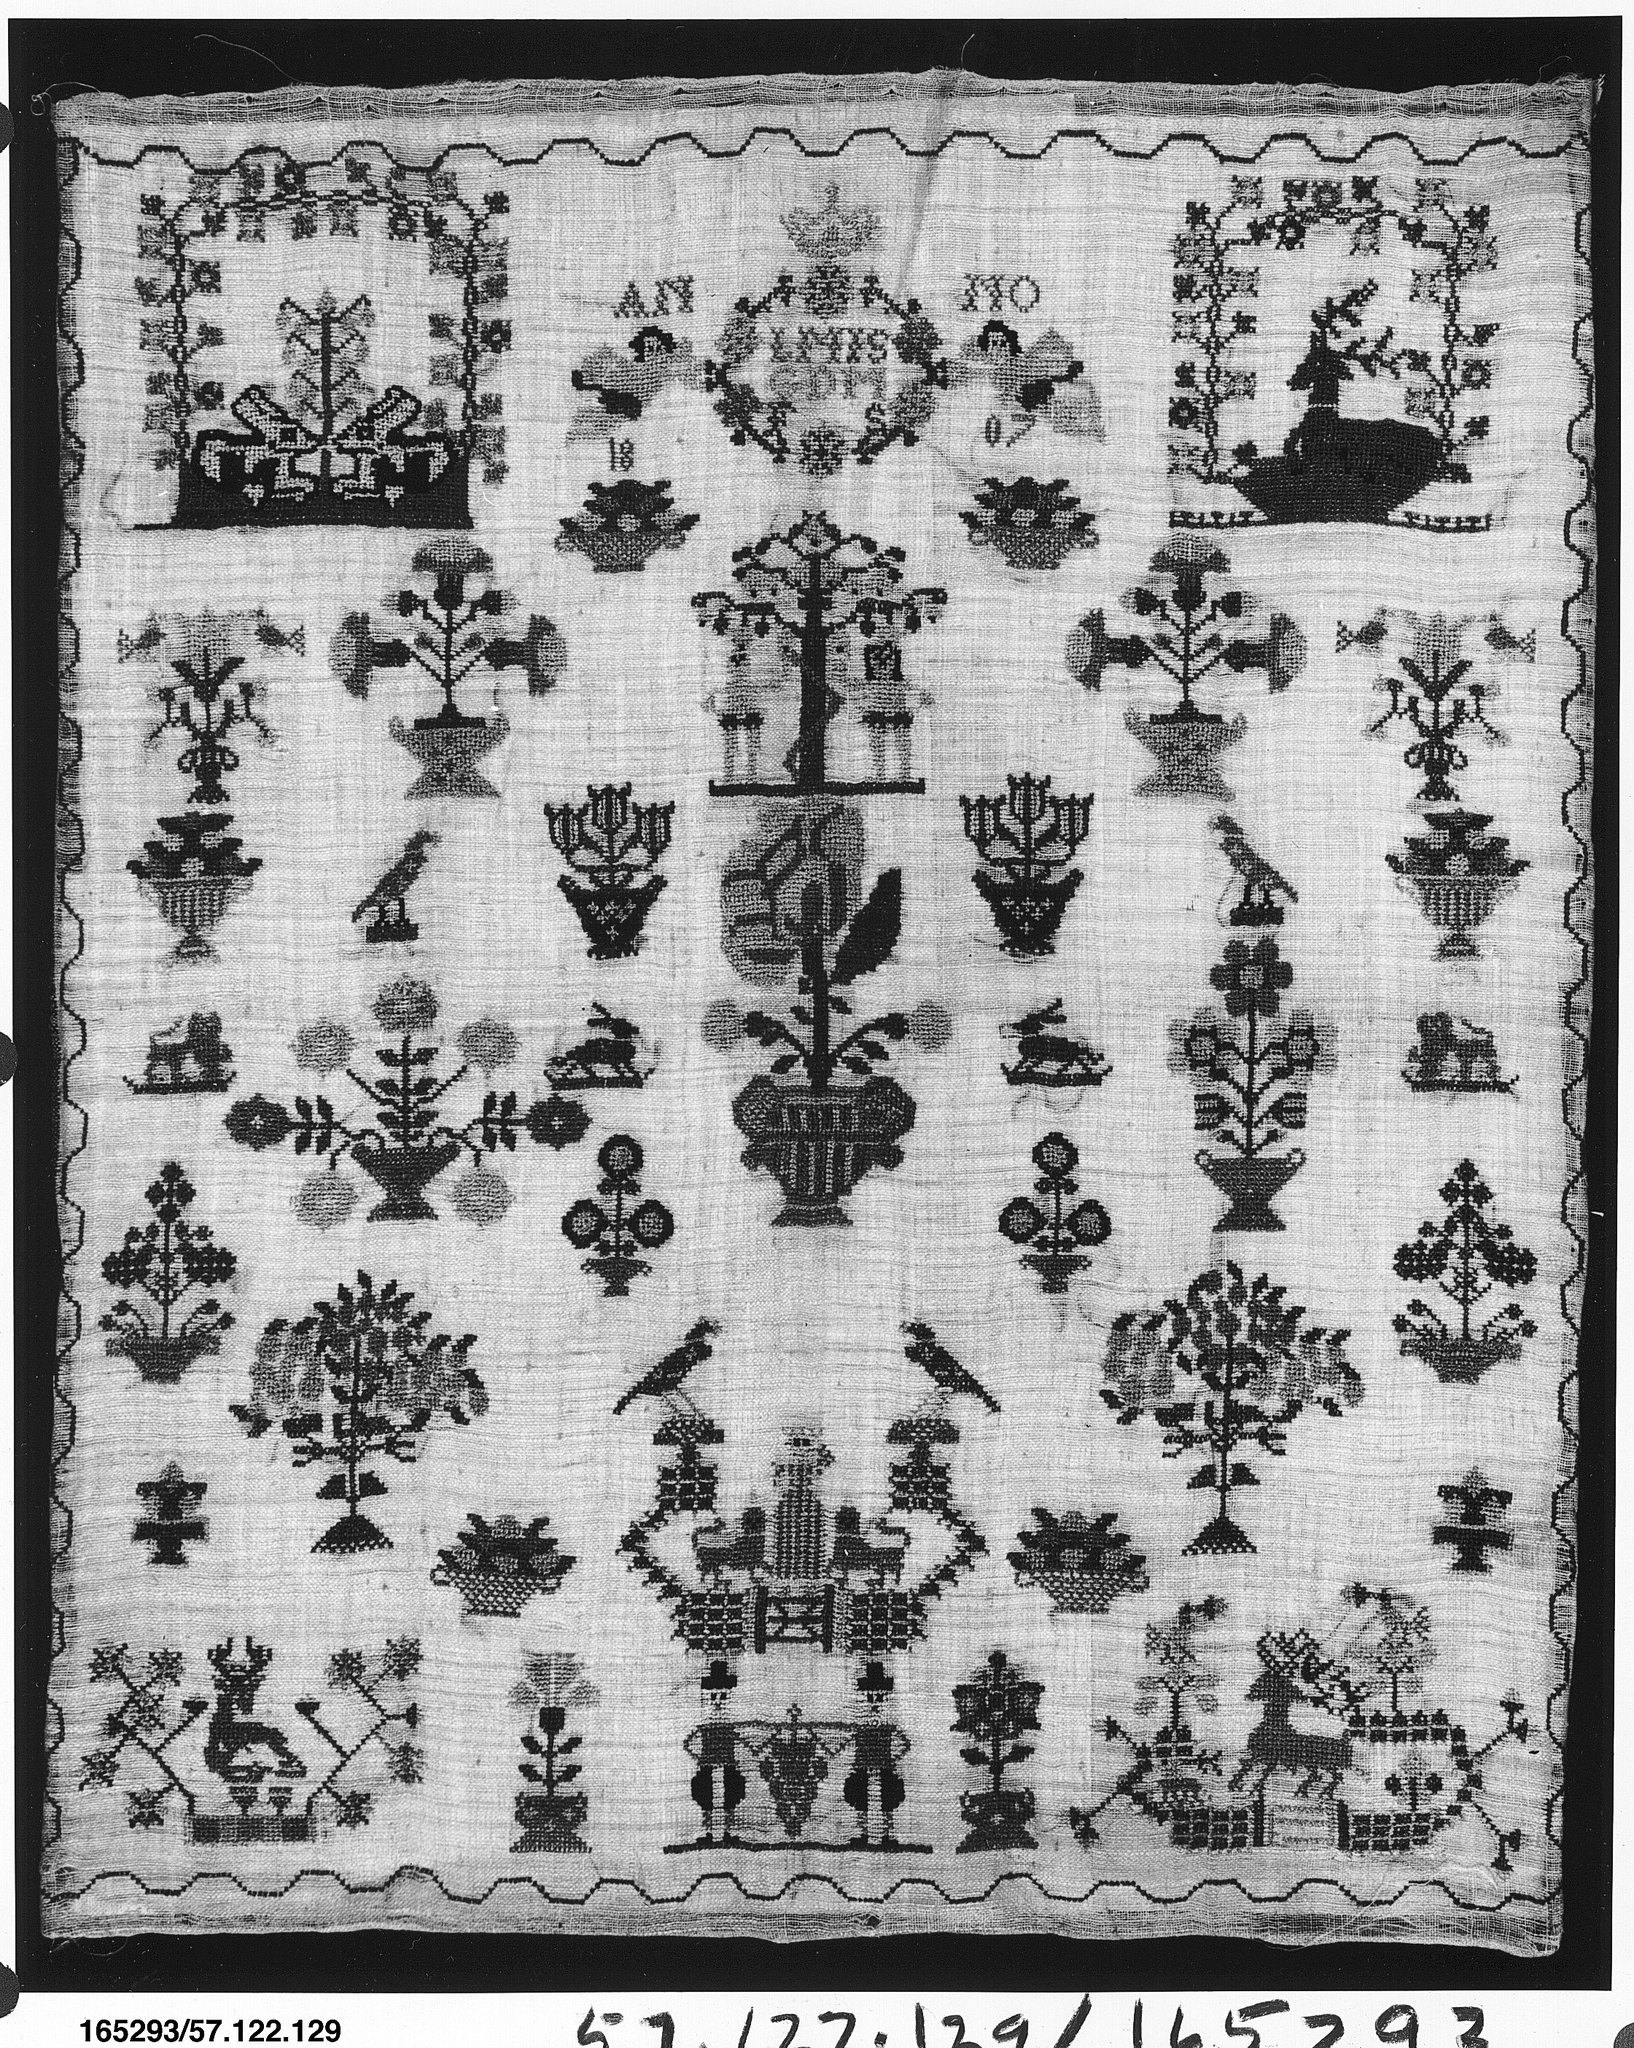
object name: sampler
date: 1807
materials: cotton, silk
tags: human figures,birds,flowers